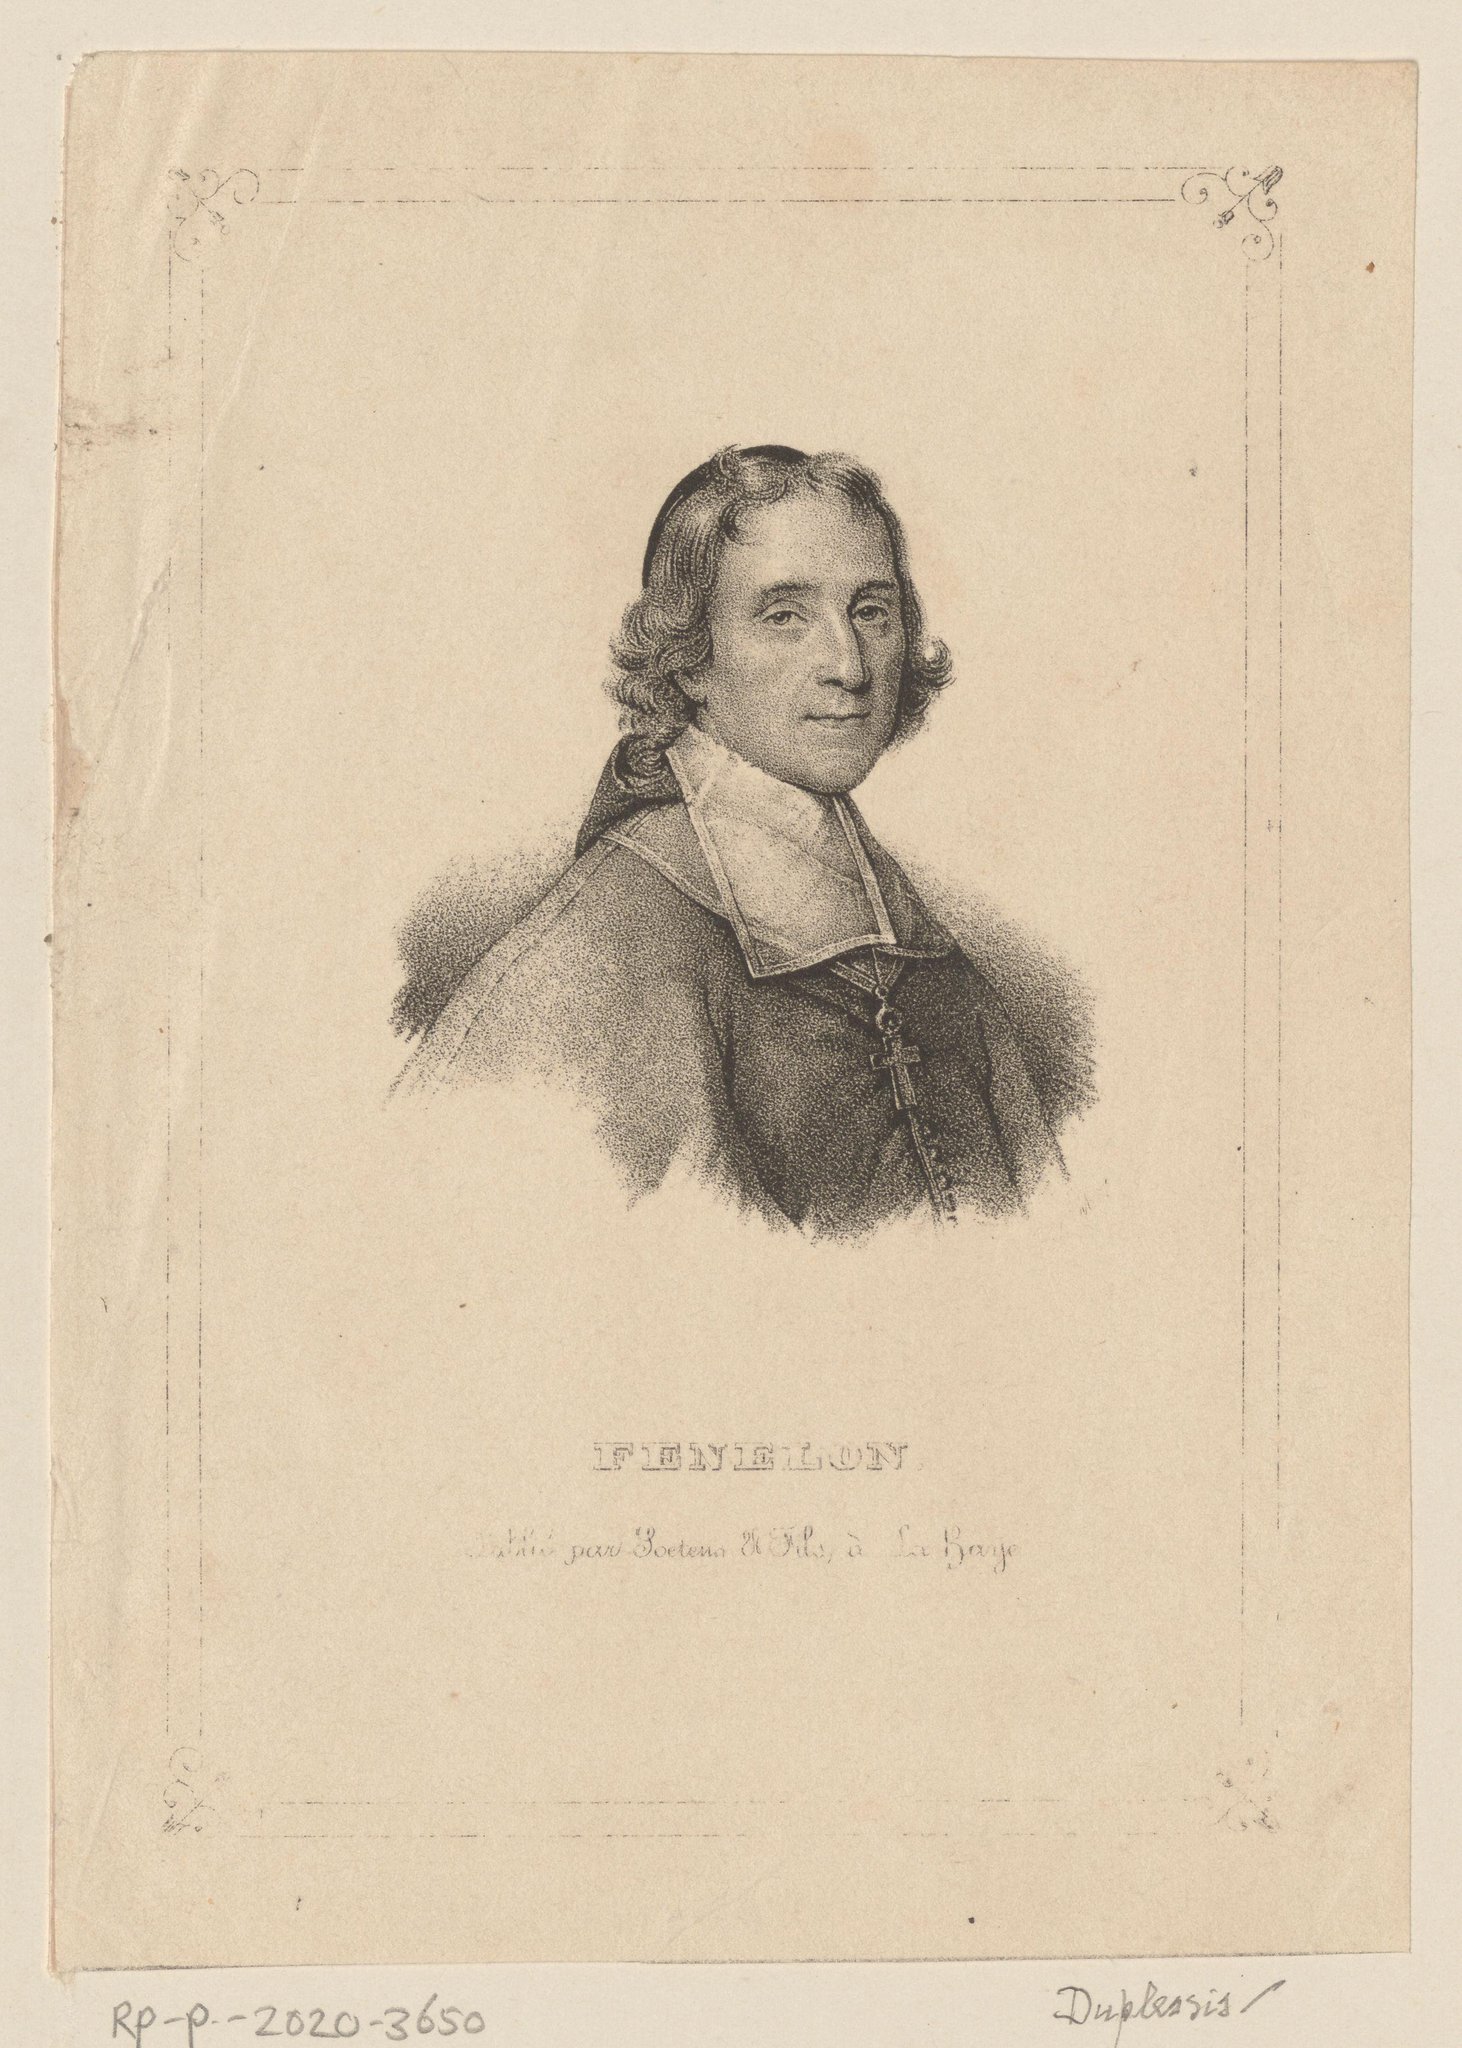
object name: print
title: Portret van François Fénelon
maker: nicolaas martinus schild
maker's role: draughtsman, print maker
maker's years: 1822-1840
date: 1837-1840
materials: paper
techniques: lithograph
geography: the hague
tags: françois fénelon, historical persons, portrait of a writer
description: Deze prent maakte vermoedelijk deel uit van een serie uitgegeven door Soetens & Fils omstreeks 1838, opgedragen aan de Prins van Oranje. In de 'Prospectus en Inteekenlijst' stond vermeld dat het zal bestaan uit een onbepaald aantal portretten, waarvan er drie of vier per maand verschijnen. Zie Van Someren.